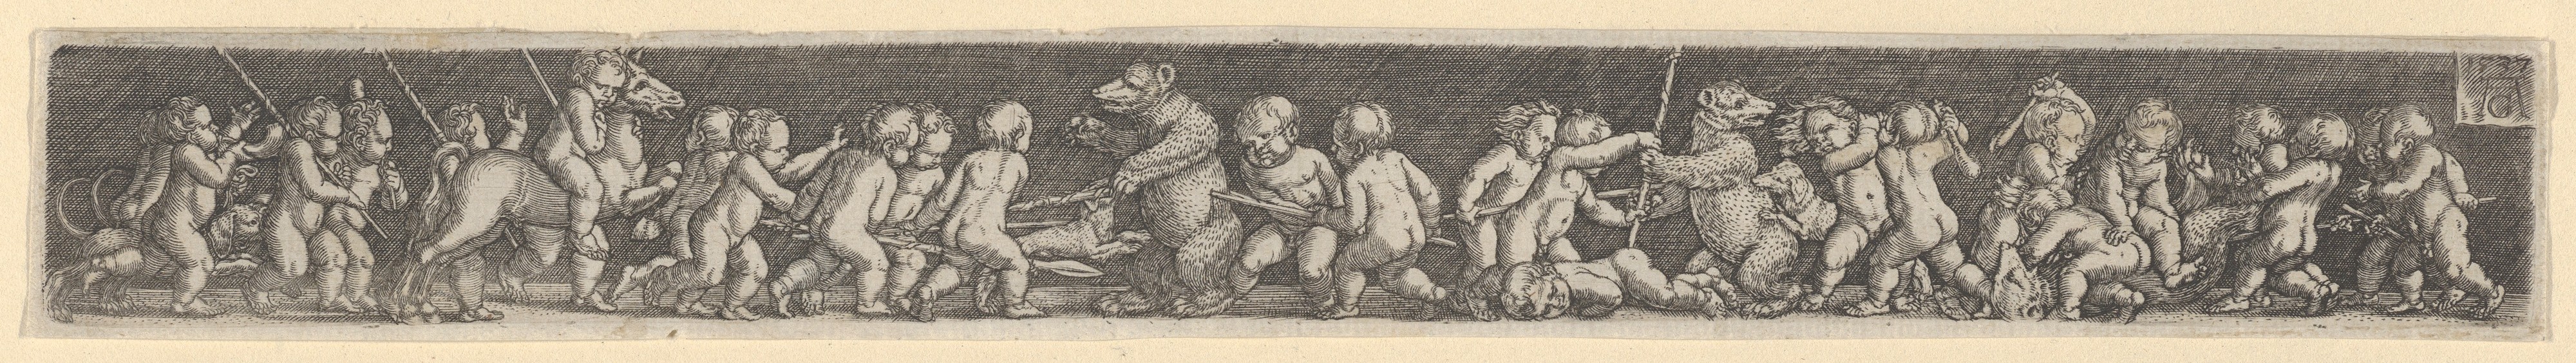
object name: print ornament architecture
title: Frieze with Children Fighting Bears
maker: heinrich aldegrever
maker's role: artist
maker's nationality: german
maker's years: 1502-1561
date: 1537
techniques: engraving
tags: bears,children,horses